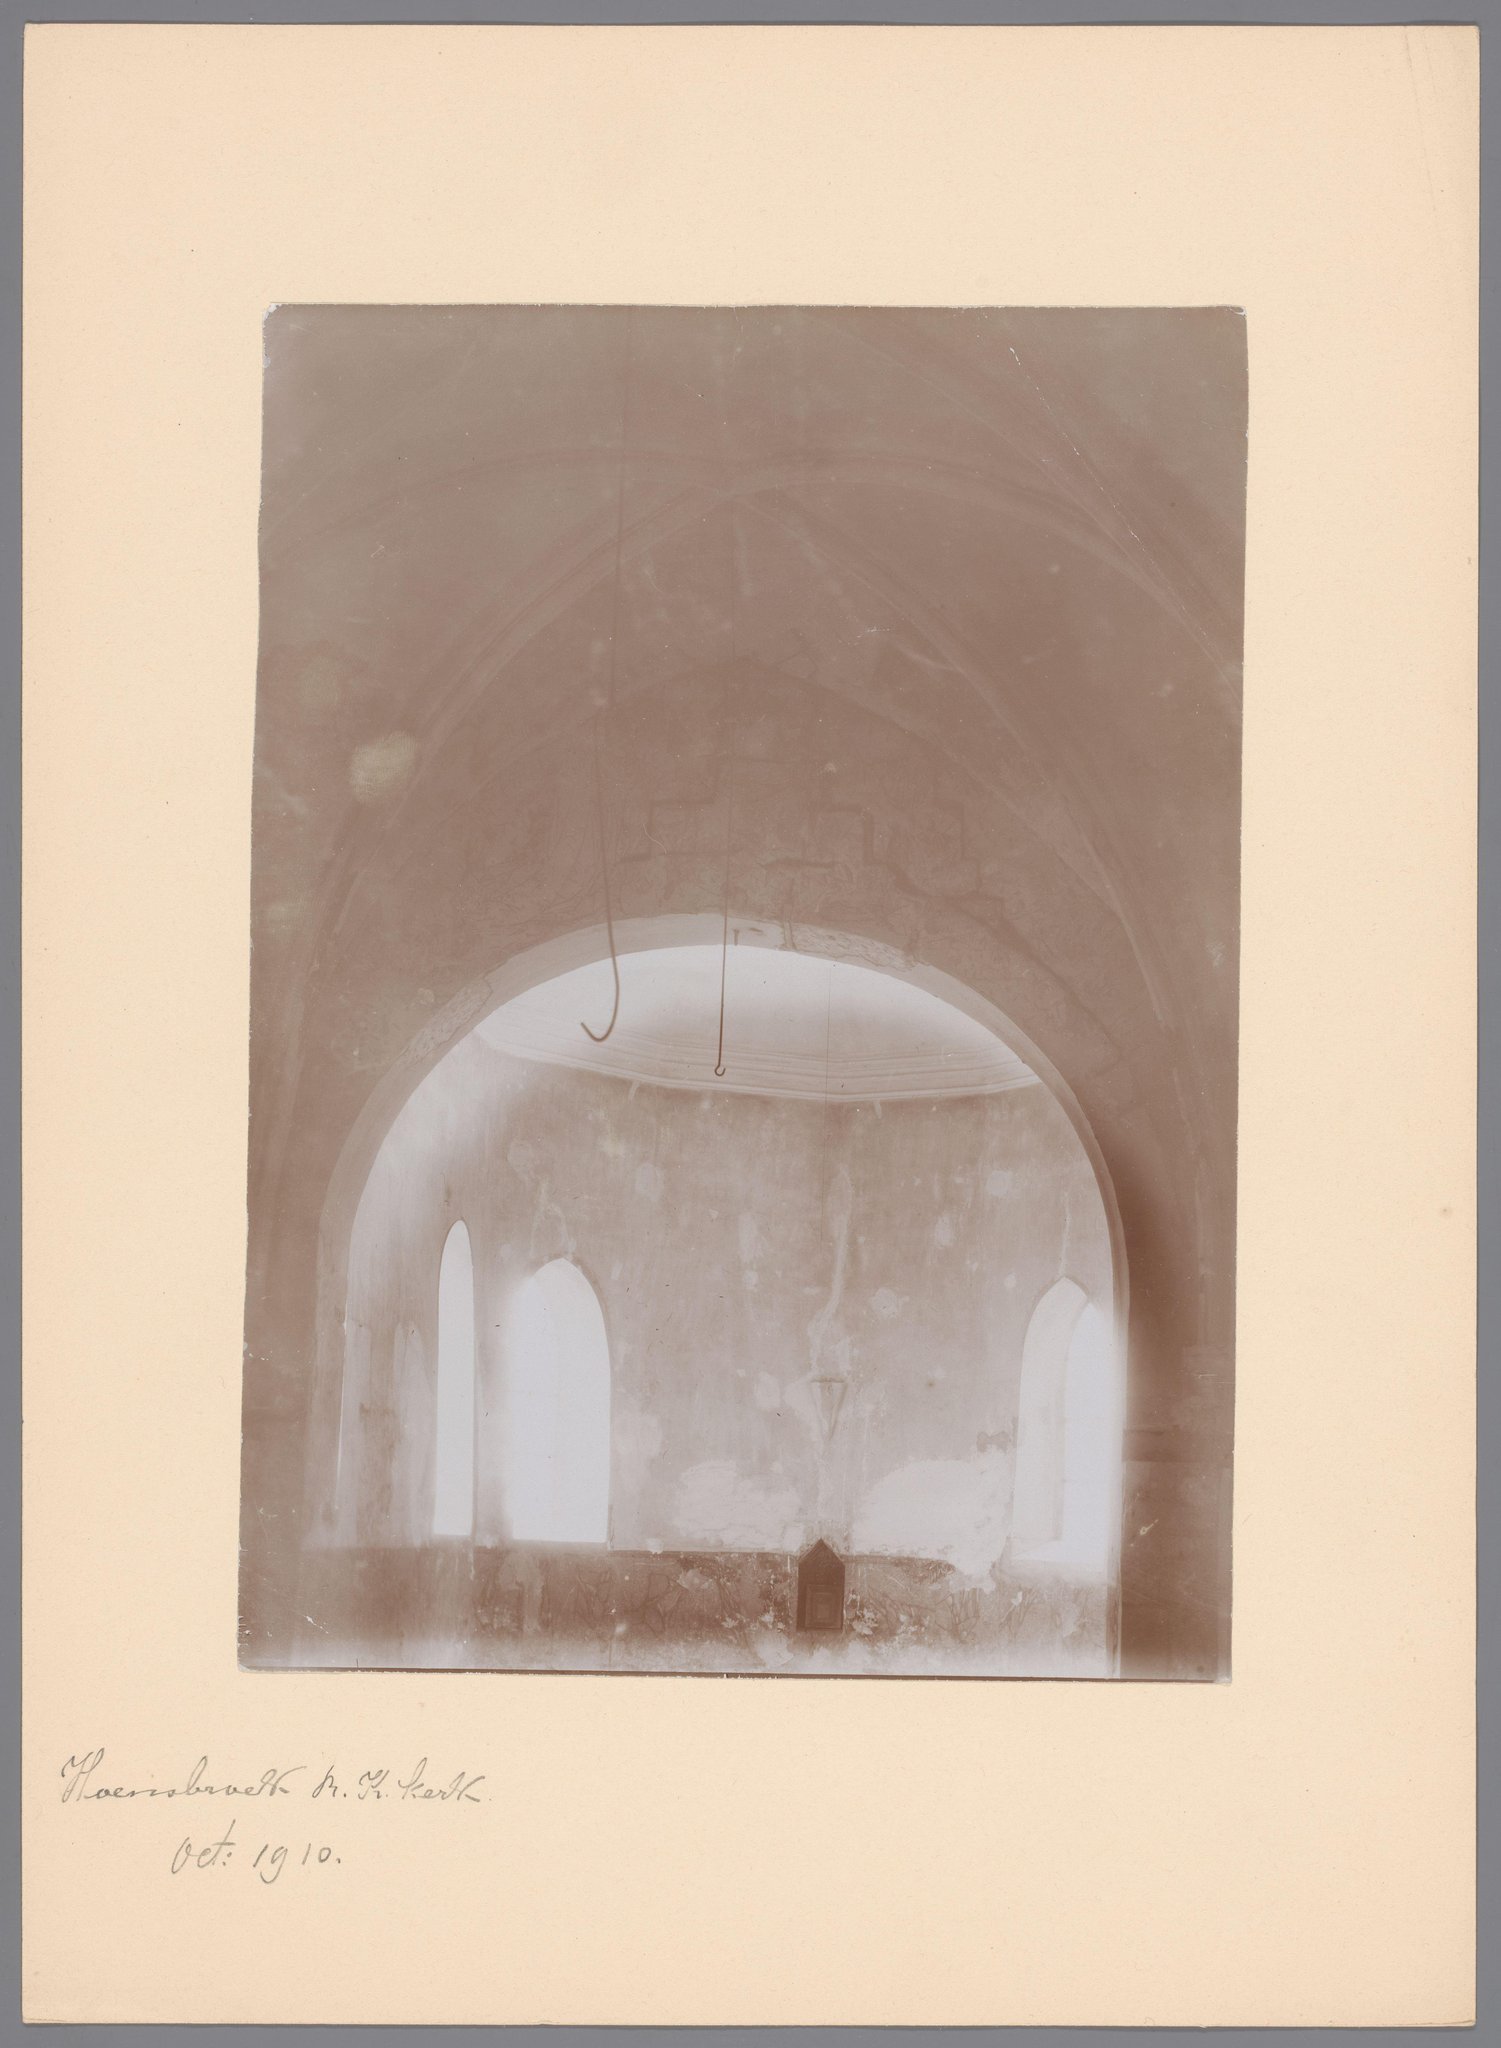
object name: photograph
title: Interieur van de Sint-Janskerk te Hoensbroek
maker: anoniem (monumentenzorg)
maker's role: fotograaf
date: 1910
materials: cardboard, photographic support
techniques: collodion silver print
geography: hoensbroek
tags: interior of church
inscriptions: annotation: ‘Hoensbroek R.K. Kerk/ oct: 1910’